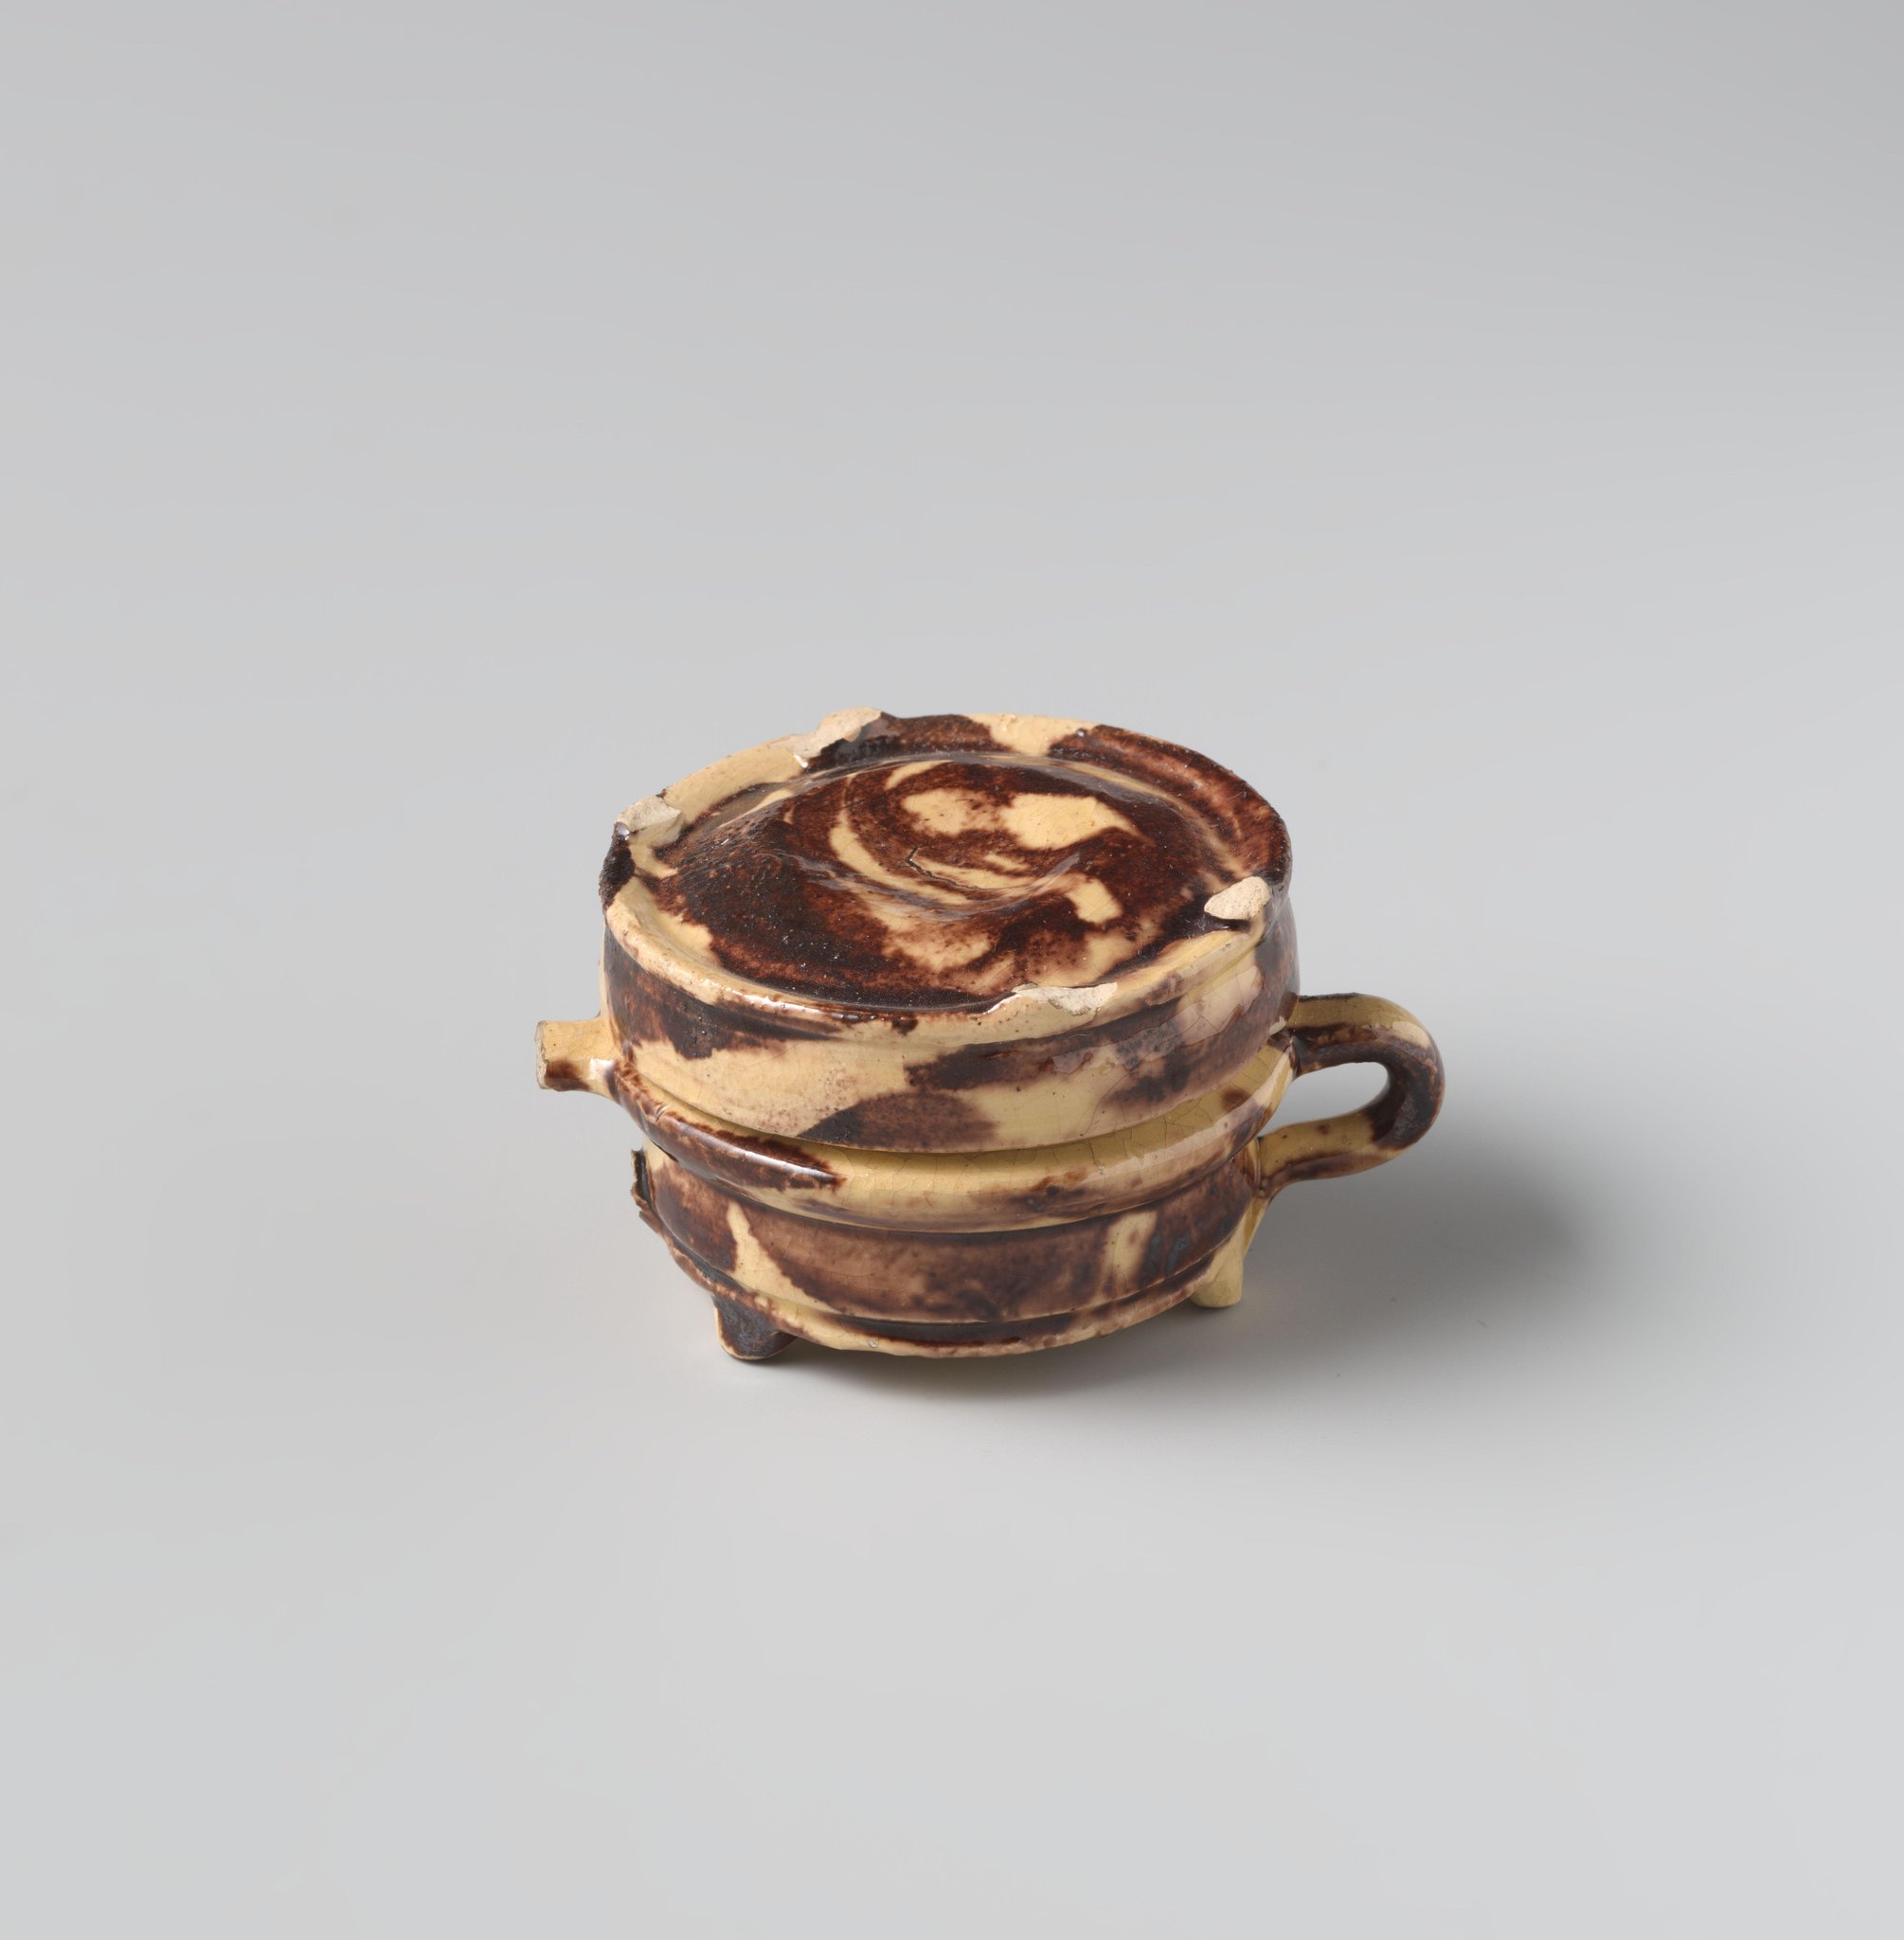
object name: miniature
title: Taartpan met deksel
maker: Anonymous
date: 1675-1699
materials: earthenware, glaze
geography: netherlands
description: Taartpan met deksel, vervaardigd van aardewerk met gele scherf en vlekkerig bruingevlekte loodglazuur. De pan staat op drie poten en had oorspronkelijk twee oren, de platte deksel met iets opstaande rand, waarop oorspronkelijk ook twee oren.